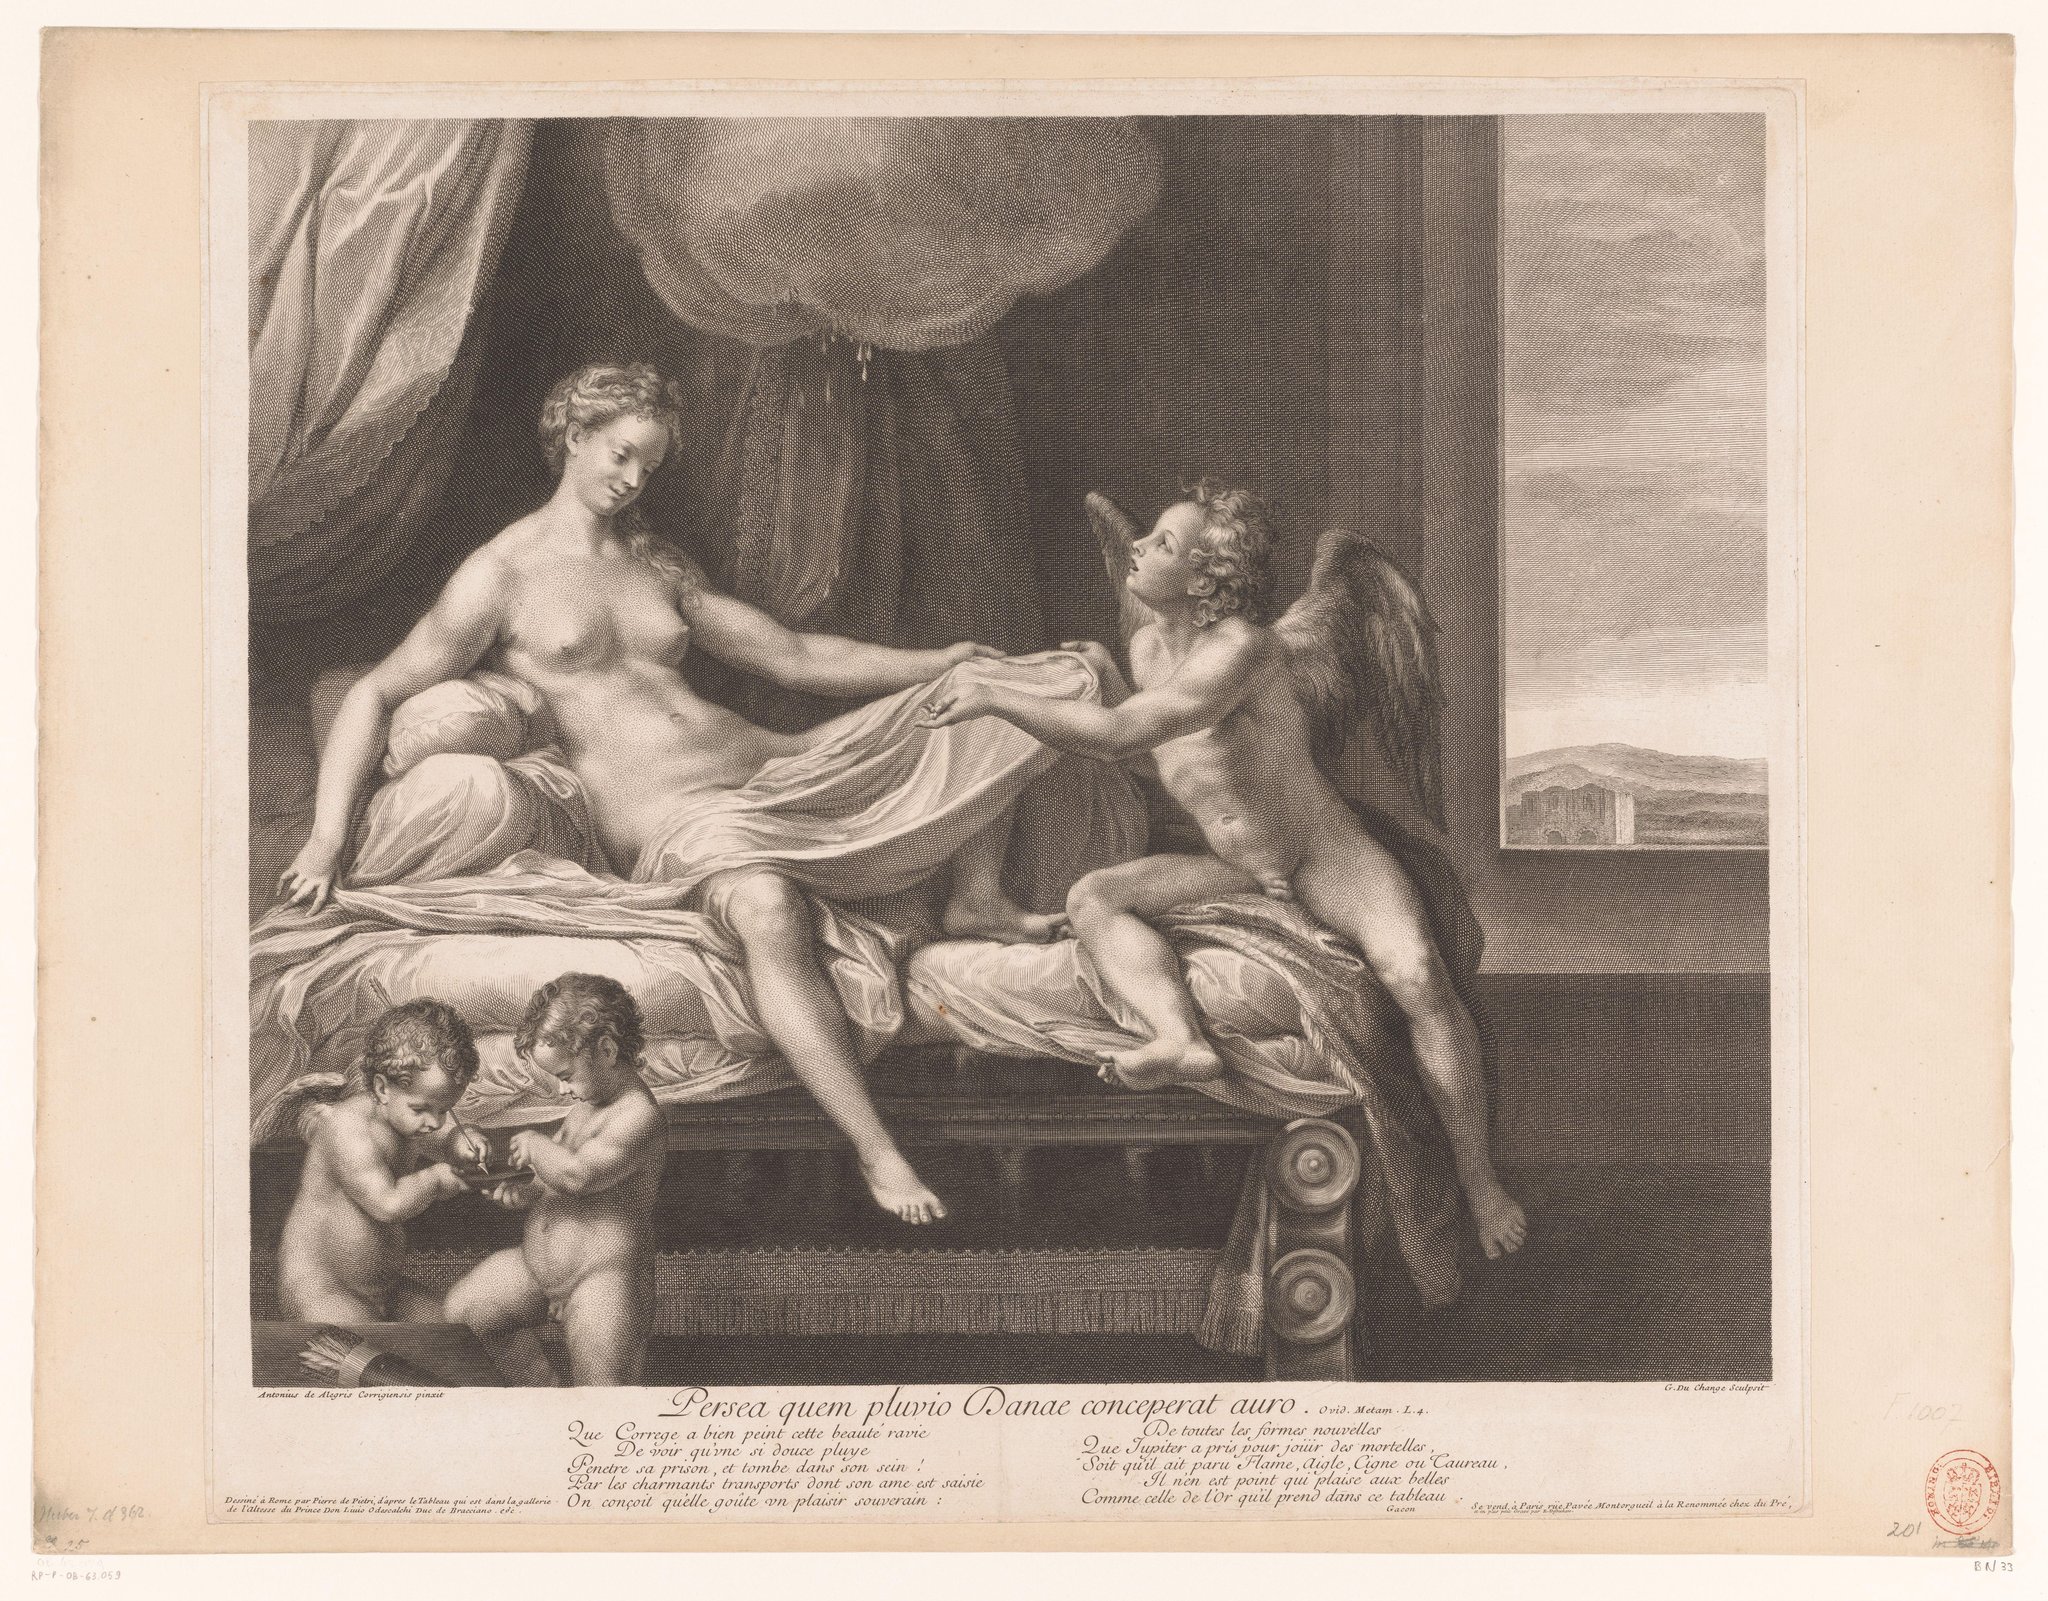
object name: print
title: Jupiter en Danaë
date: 1704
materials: paper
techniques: engraving, etching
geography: paris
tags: (story of) cupid, amor (eros), jupiter wooing danae; she is usually lying in bed receiving a shower of gold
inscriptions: collector's mark: Lugt 240